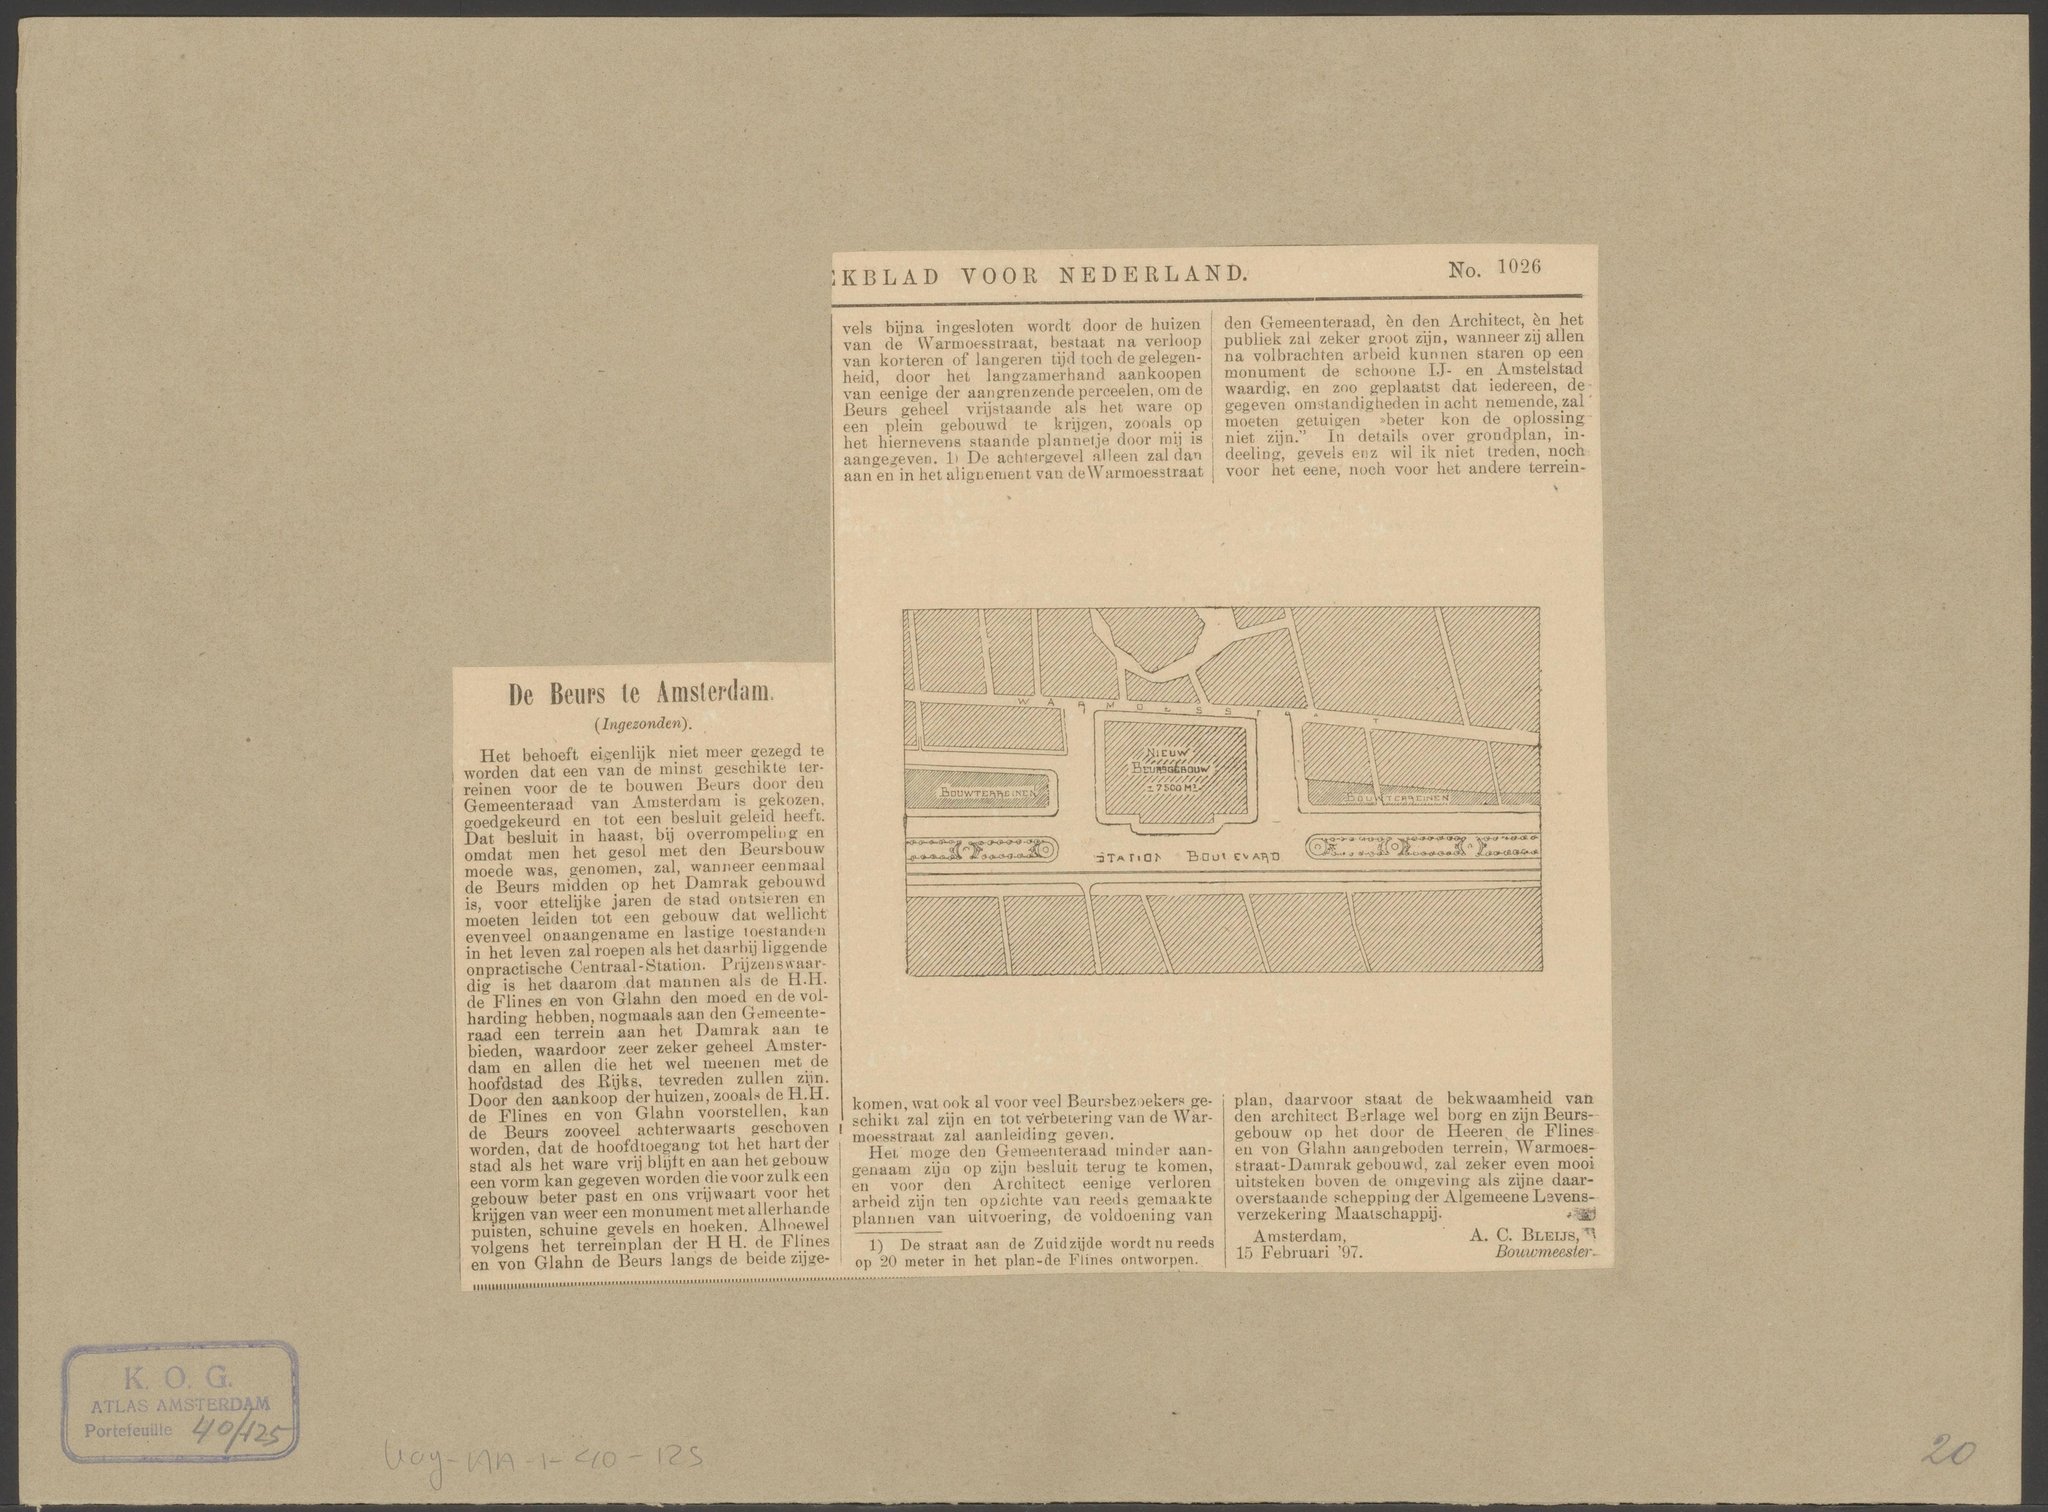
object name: photomechanical print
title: Plattegrond van het Beursgebouw te Amsterdam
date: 1897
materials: paper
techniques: letterpress printing, line block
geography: amsterdam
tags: stock exchange, stock-market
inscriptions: collector's mark: Lugt 1641b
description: Rechtsboven genummerd: No. 1026. Onderwerpsrubriek binnen de Atlas Amsterdam: Handel en Zeevaart, D. Beurs-Ontwerpen.